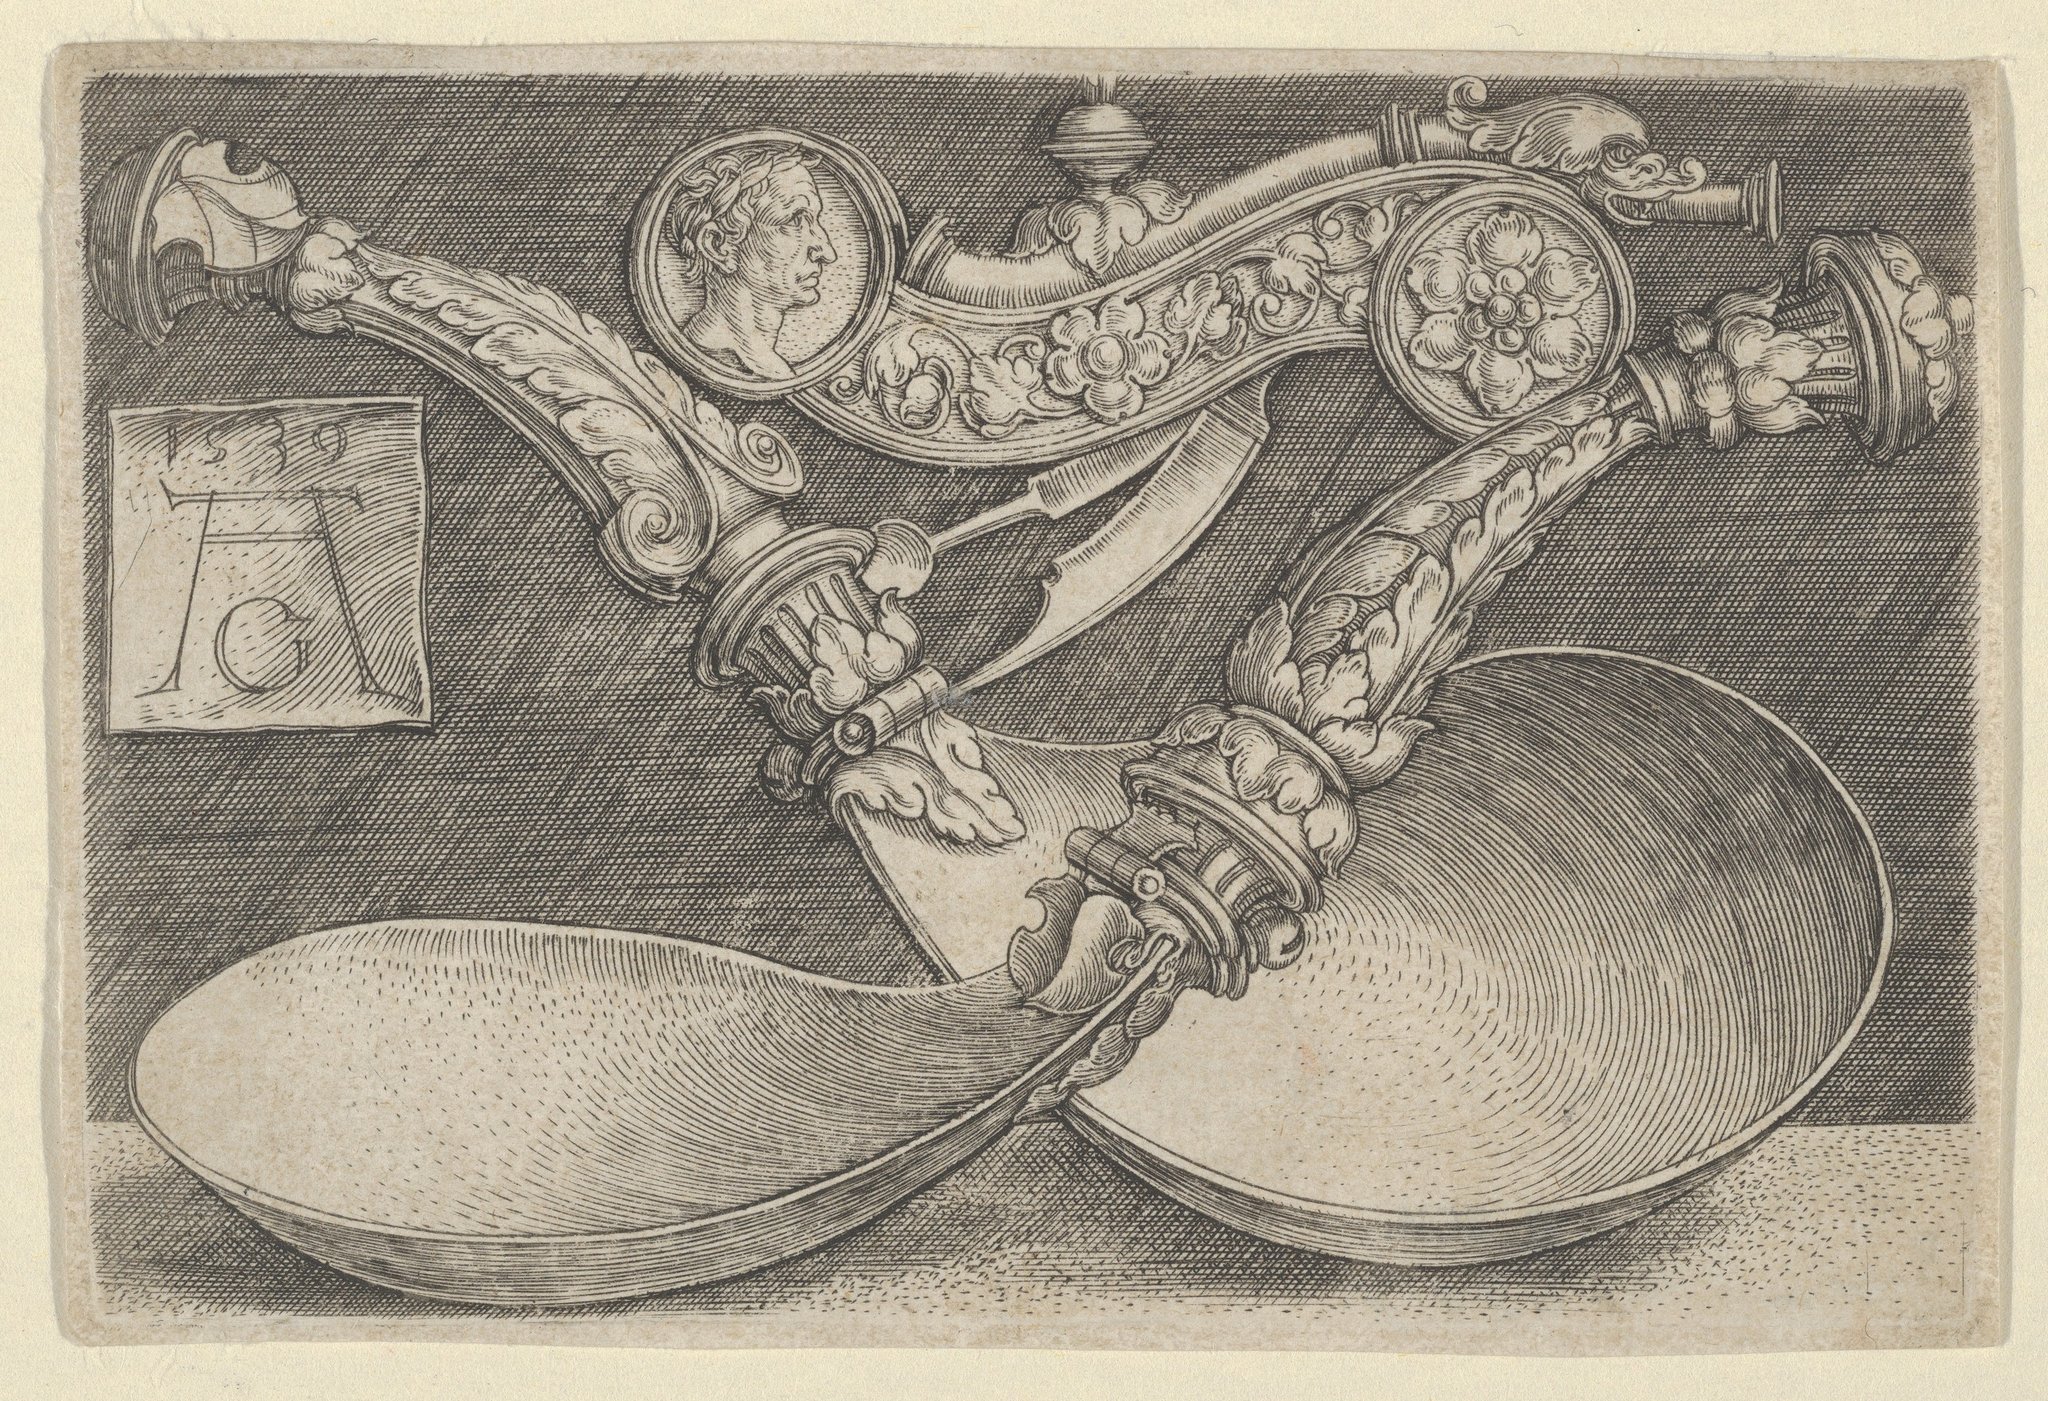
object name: print ornament architecture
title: Design for Two Spoons and a Dog Whistle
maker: heinrich aldegrever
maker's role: artist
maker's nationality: german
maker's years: 1502-1561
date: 1539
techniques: engraving